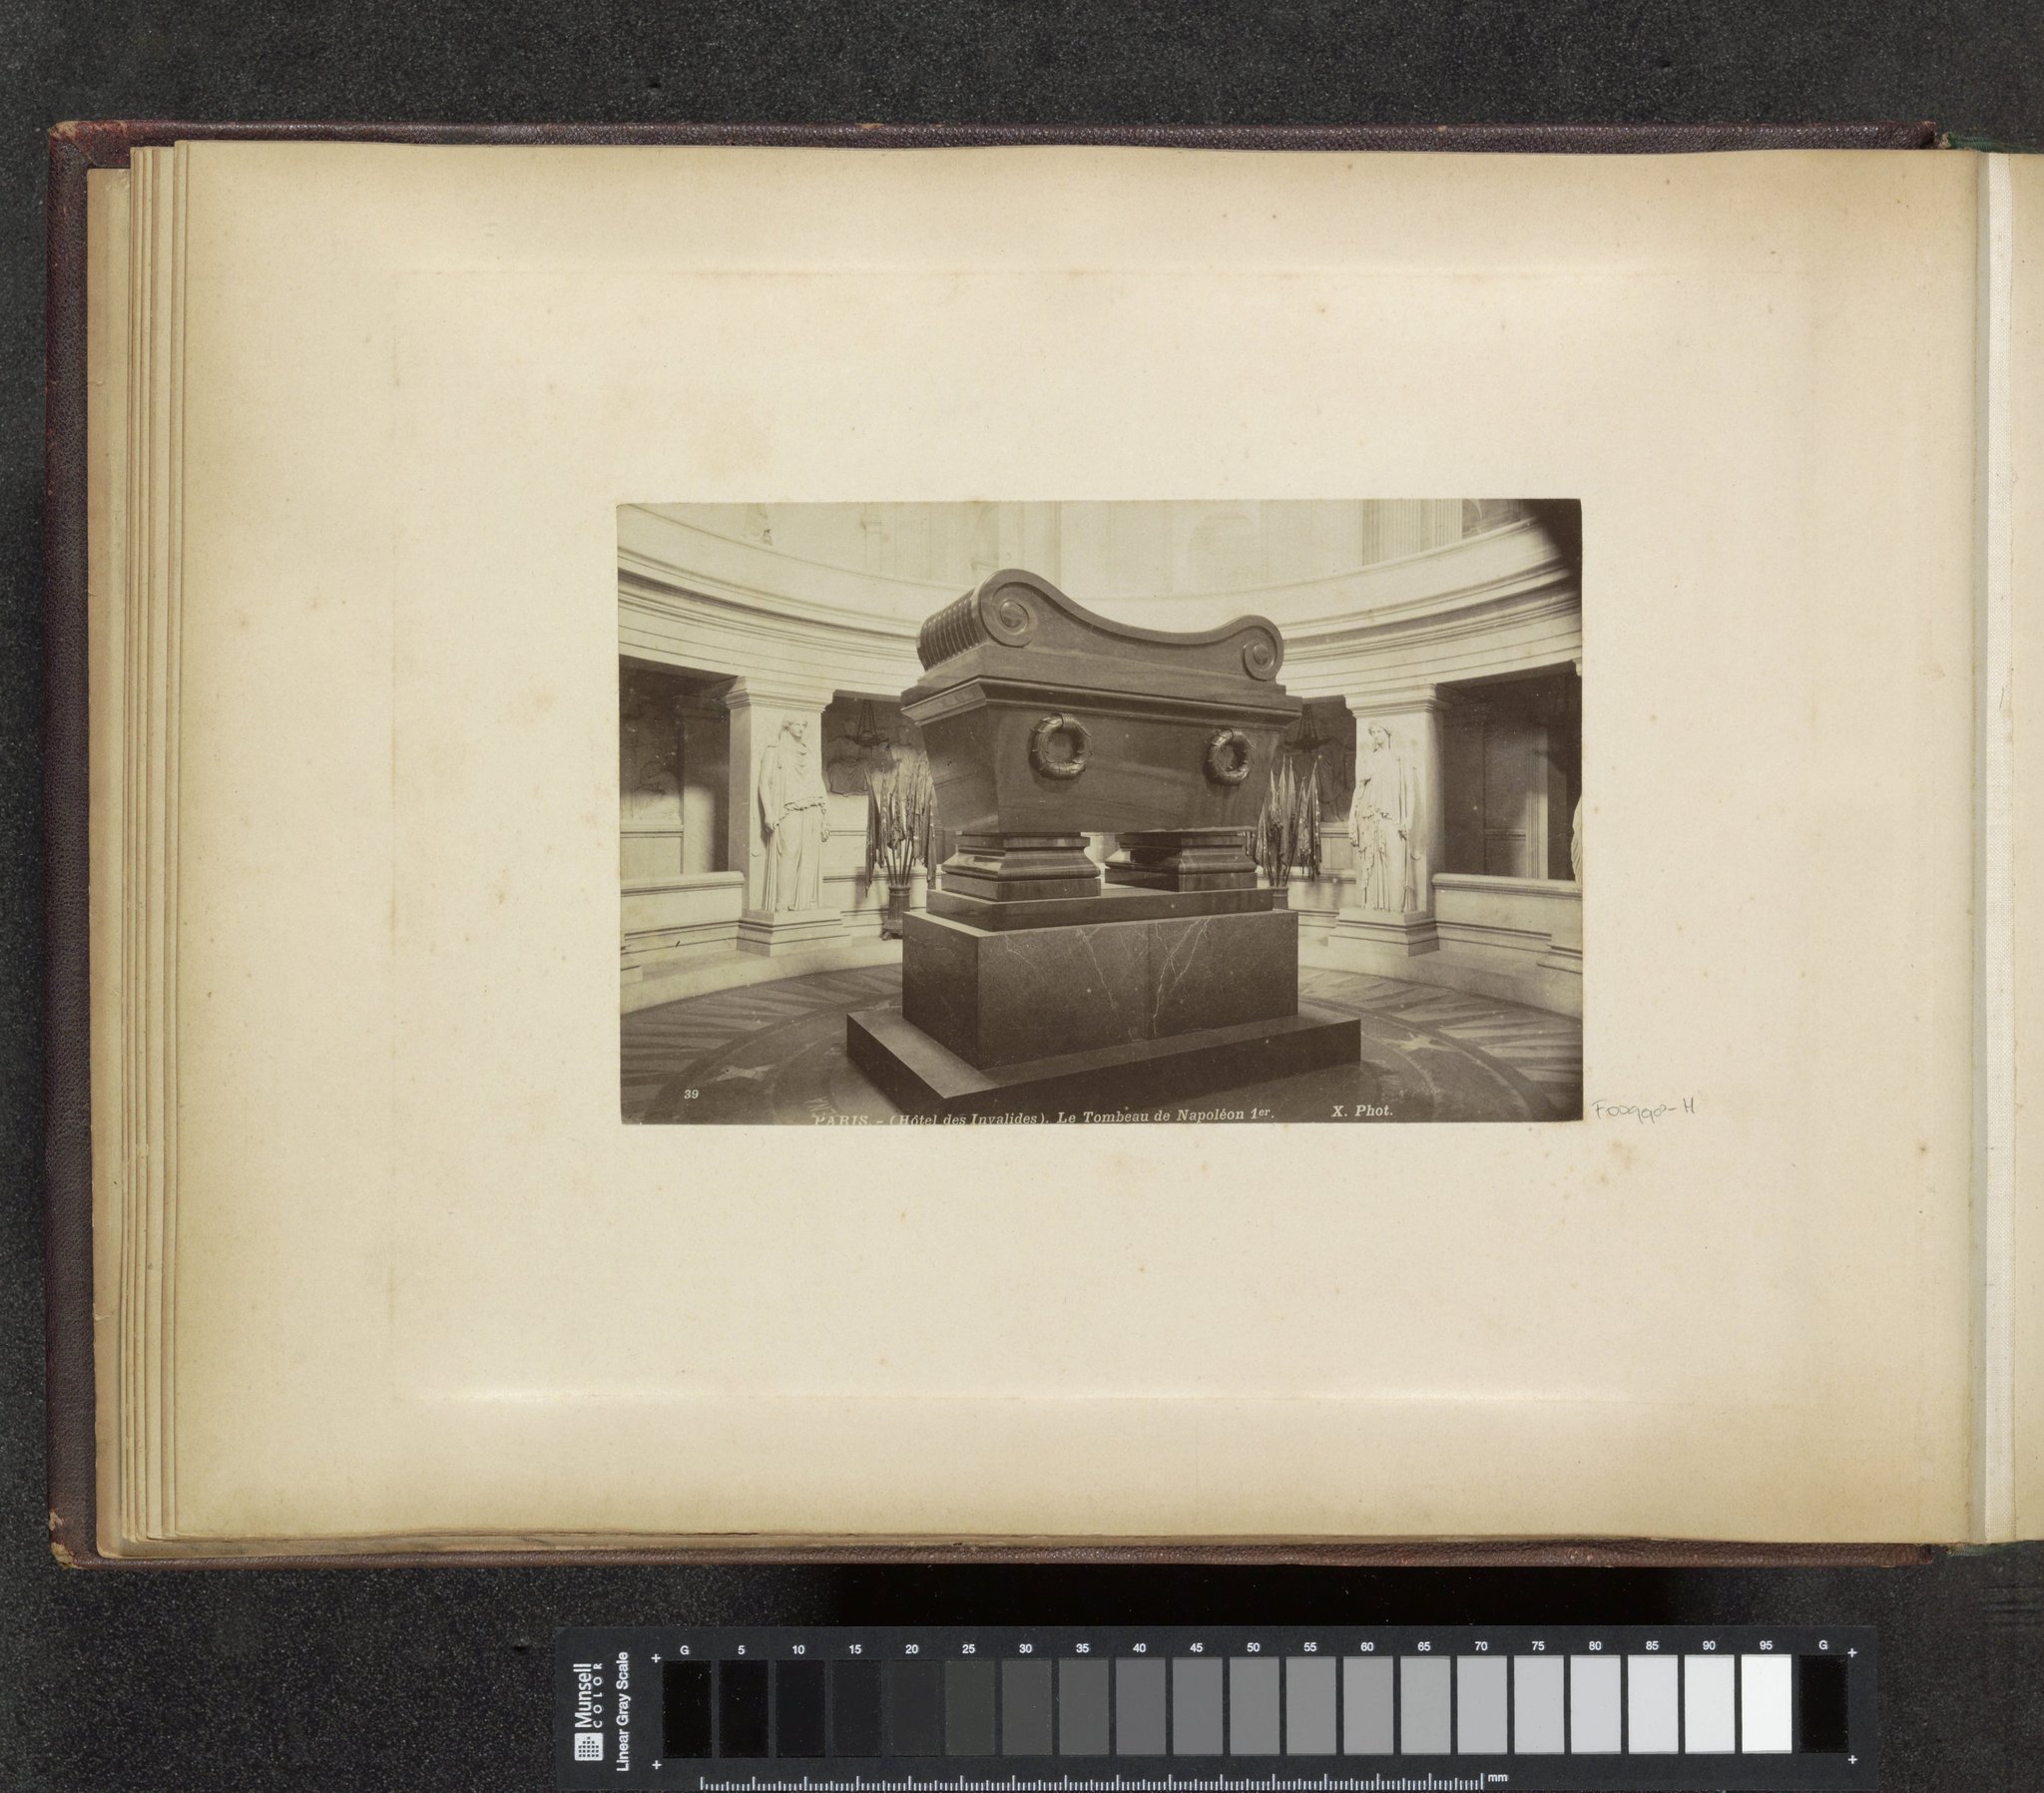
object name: photograph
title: PARIS - (Hôtel des Invalides). Le Tombeau de Napoléon 1er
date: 1880-1890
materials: paper, photographic support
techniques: albumen print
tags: grave, tomb, paris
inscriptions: negative number: ‘39’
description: Onderdeel van Reisalbum met foto's van bezienswaardigheden in Frankrijk, Griekenland en Turkije.